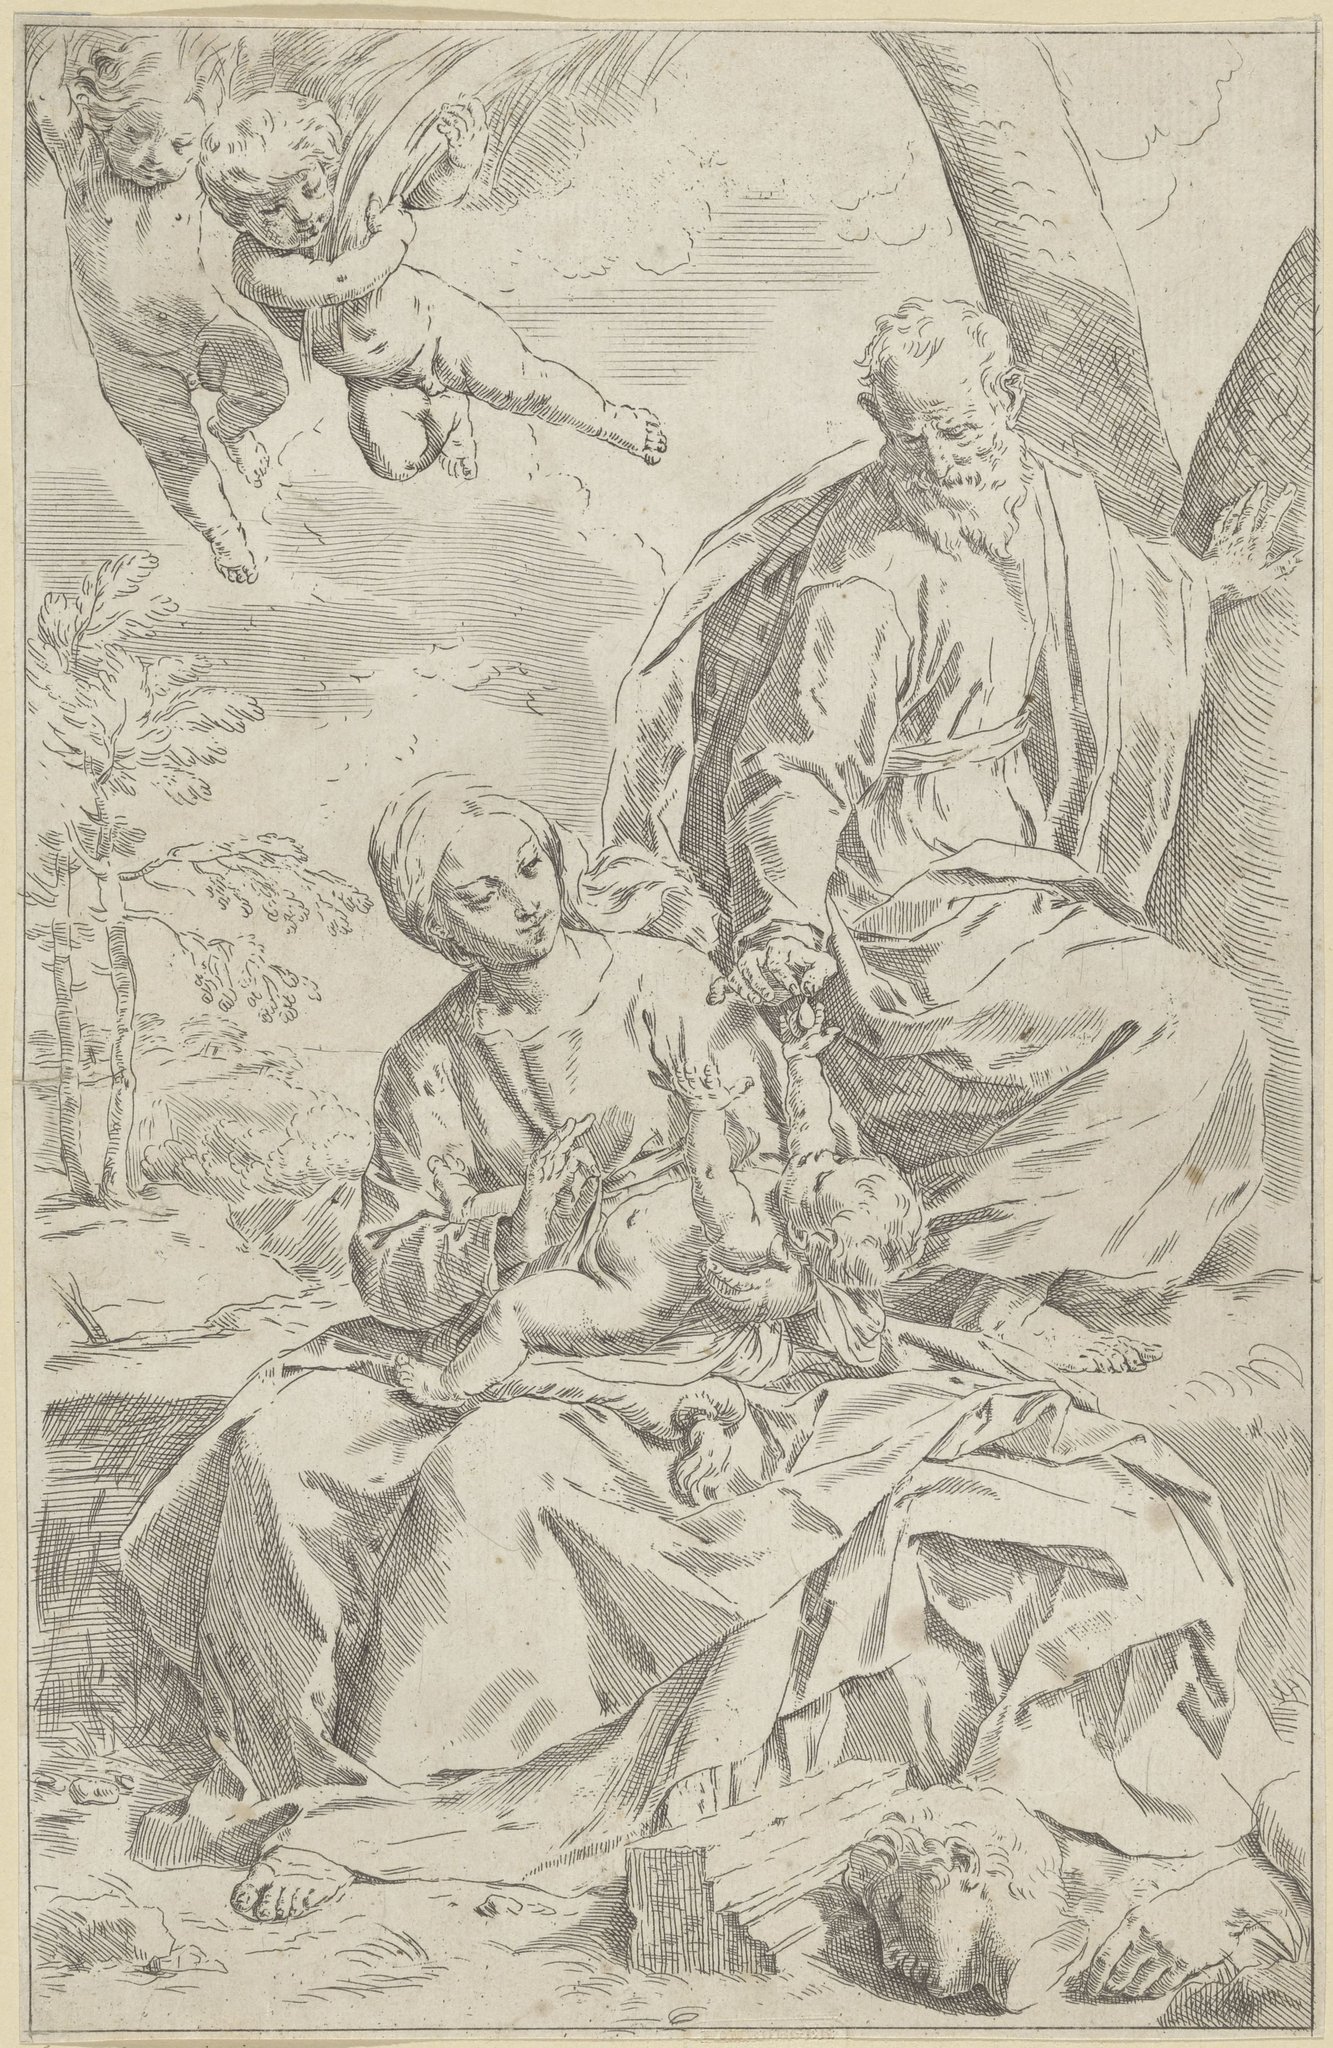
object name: print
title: Rust op de vlucht naar Egypte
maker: simone cantarini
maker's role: draughtsman, print maker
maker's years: 1612-1648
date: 1622-1648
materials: paper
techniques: etching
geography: italy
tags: rest on the flight into egypt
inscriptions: collector's mark:, collector's mark: Lugt 2228, collector's mark: Lugt 1236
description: De Heilige Familie rust onder een boom tijdens de vlucht naar Egypte. Jozef geeft een kleine vrucht aan het Christuskind dat bij Maria op schoot ligt. Linksboven twee putti.